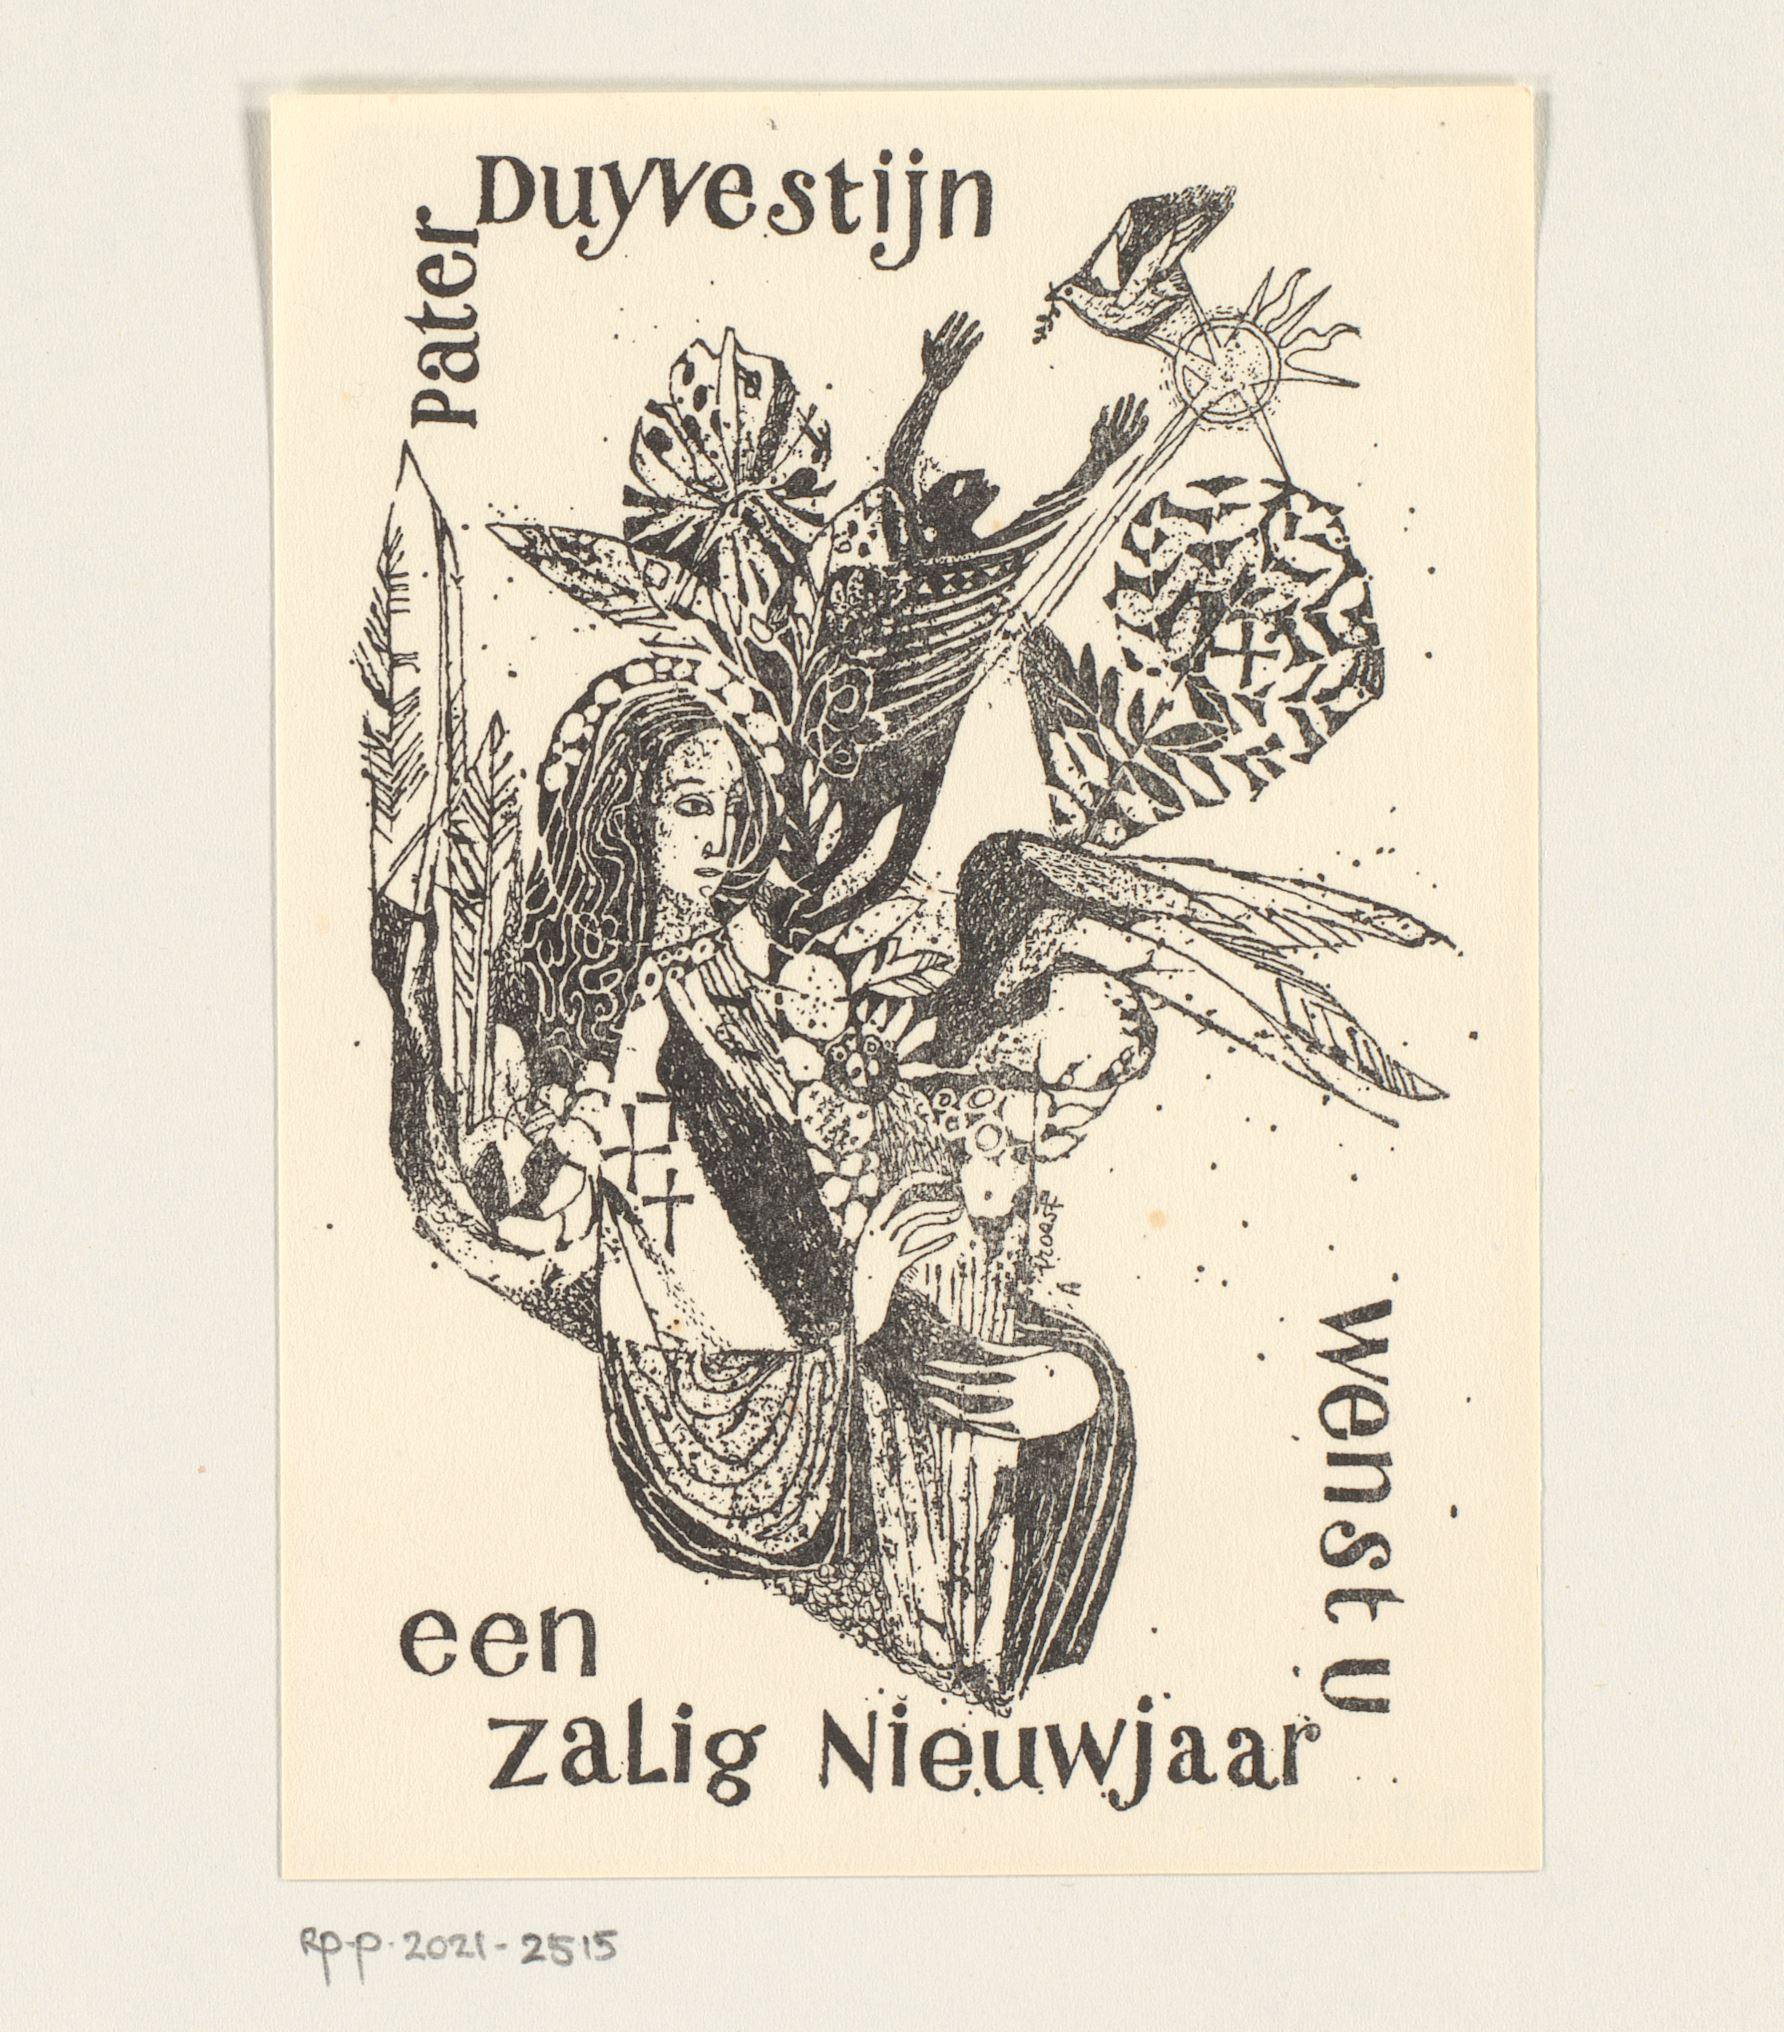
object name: photomechanical print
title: Nieuwjaarswens van pater A. Duijvestijn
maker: Anonymous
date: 1950-2000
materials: paper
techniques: printing block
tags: christmas (ecclesiastical feast), new year's eve (december 31)